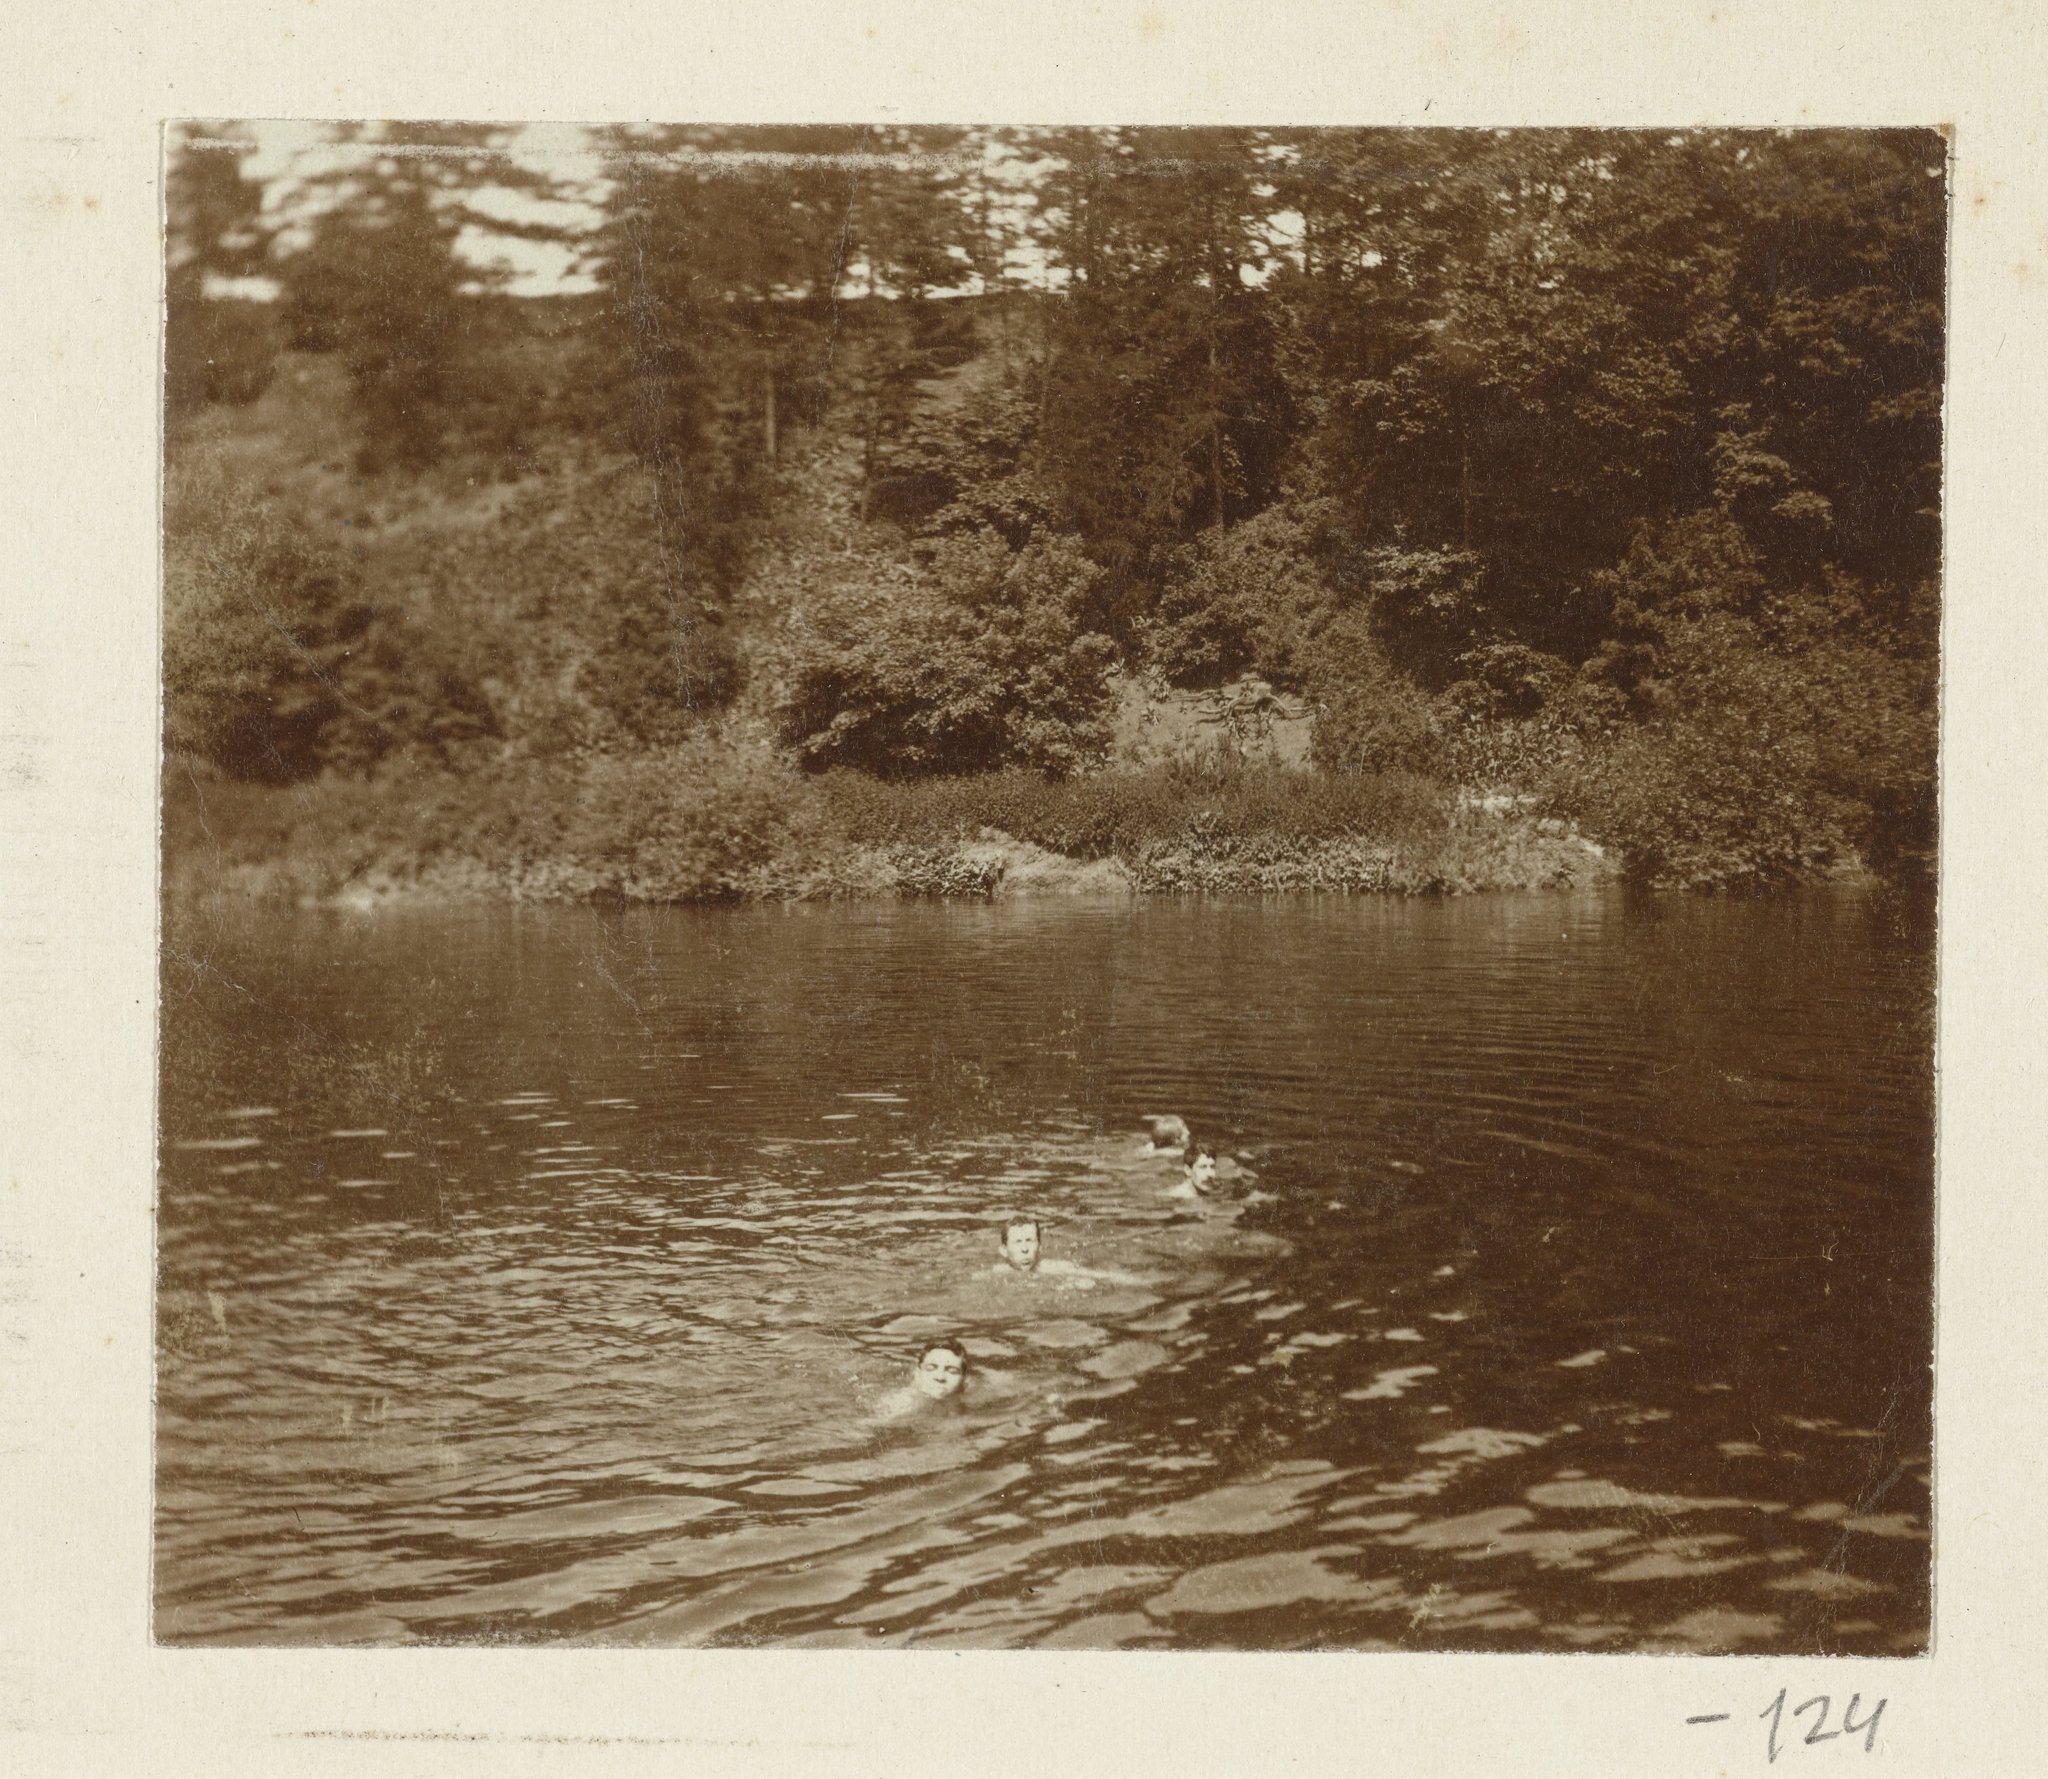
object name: photograph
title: Dolph Kessler en vrienden zwemmen in een vijver of de rivier de Trent in Gainsborough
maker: geldolph adriaan kessler (dolph)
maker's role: fotograaf, industrieel, voetballer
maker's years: 1884-1945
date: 1903-1904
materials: cardboard, photographic support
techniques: gelatin silver print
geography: gainsborough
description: Dolph Kessler en vrienden zwemmen in een vijver of de rivier de Trent in Gainsborough. Onderdeel van het fotoalbum van Dolph Kessler met opnamen die hij maakte tijdens zijn verblijf in Engeland en op een wereldreis die hij als secretaris van Henri Deterding (directeur Koninklijke Olie) ondernam naar Nederlands-Indië, Japan, China en de Verenigde Staten, tussen 1906 en 1908.